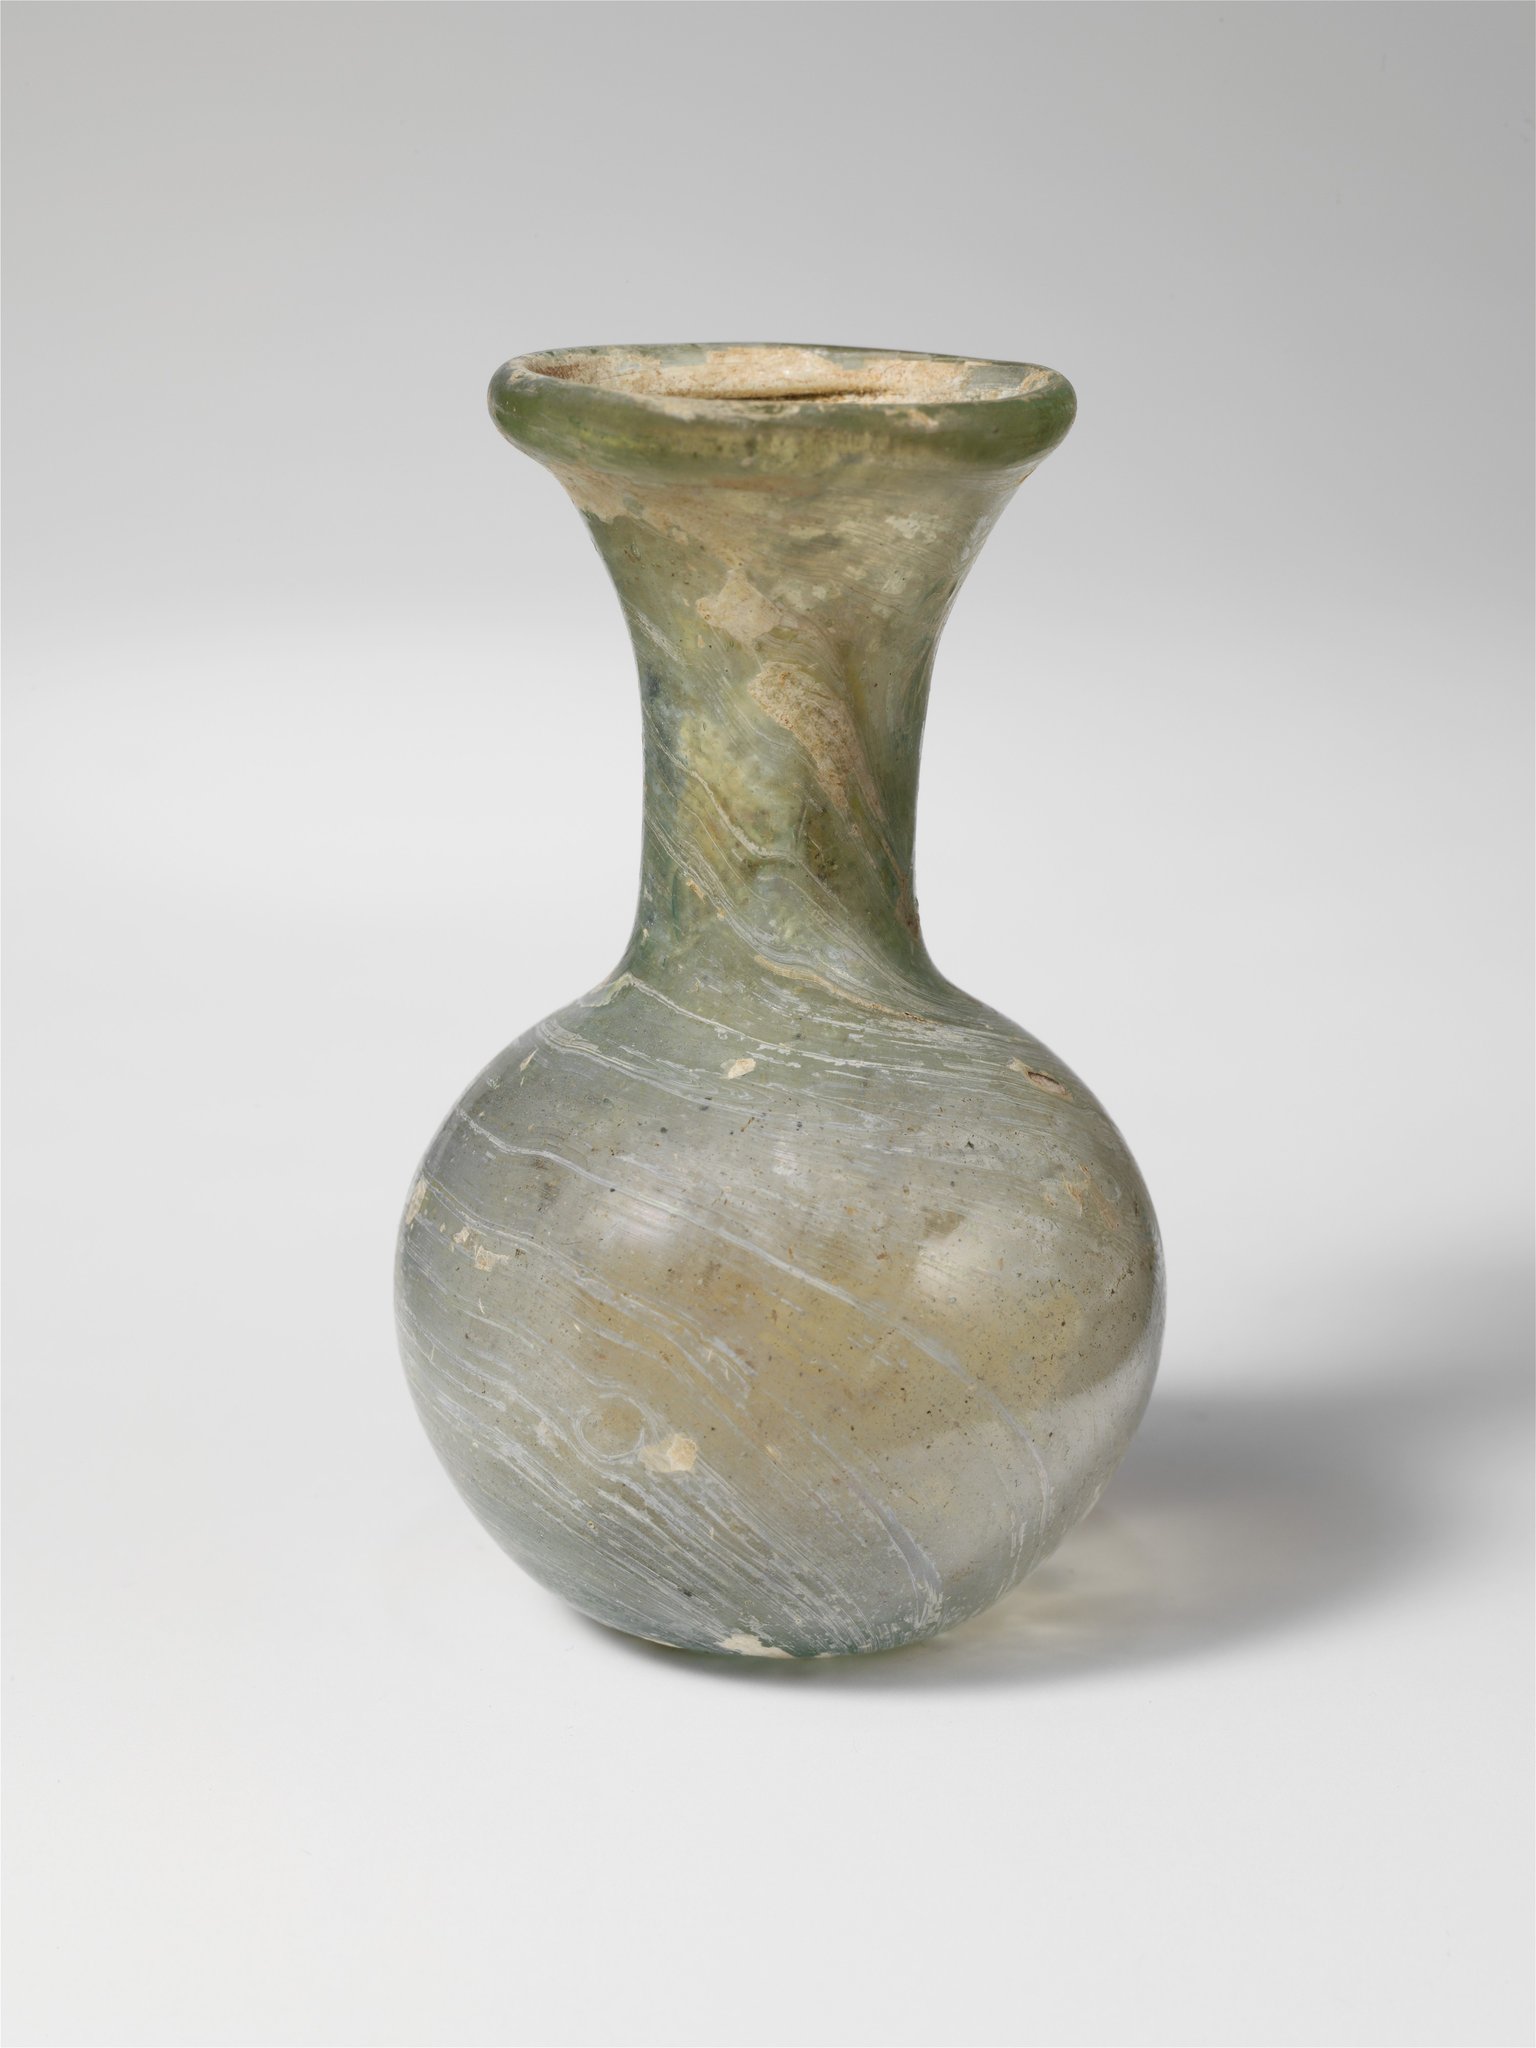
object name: flask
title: Glass flask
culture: roman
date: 201-400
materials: glass